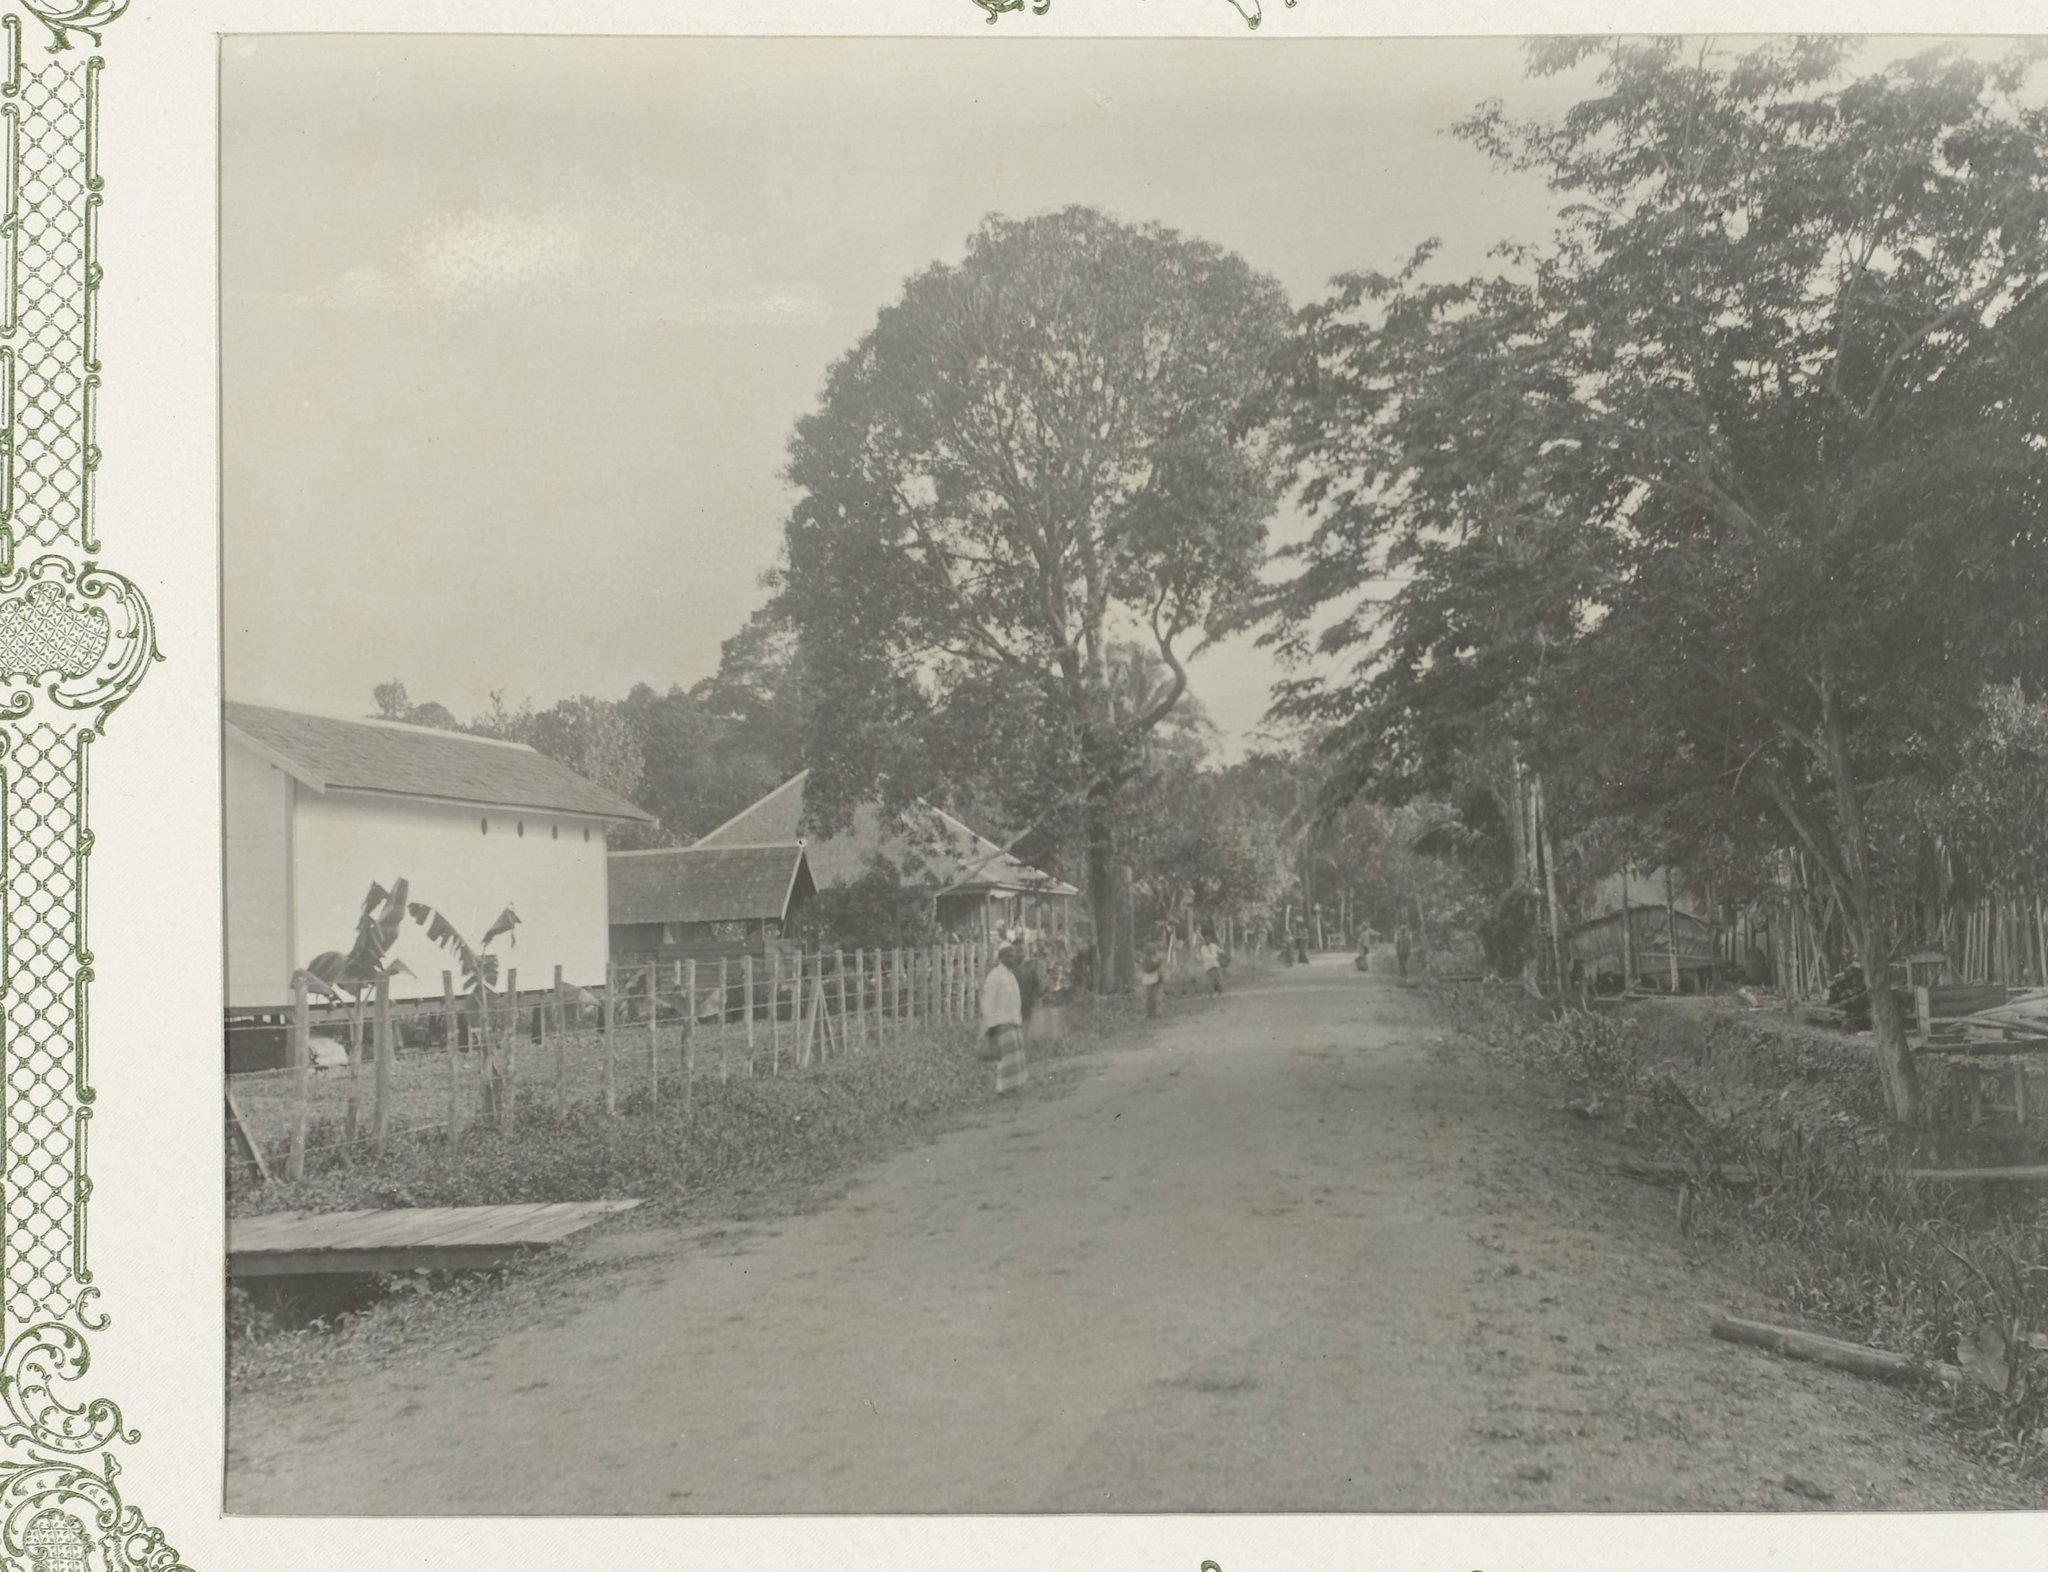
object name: album leaf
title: Gezicht in een dorp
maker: Anonymous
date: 1903-1907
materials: paper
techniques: gelatin silver print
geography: kalimantan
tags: lake, borneo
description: Gezicht op een weg in een dorp met huizen aan weerszijden, in de verte een straatlantaarn. Foto in het fotoalbum over de oliewinning op Borneo door de Koninklijke Nederlandsche Petroleum Maatschappij (KNPM) in de jaren 1903-1907.